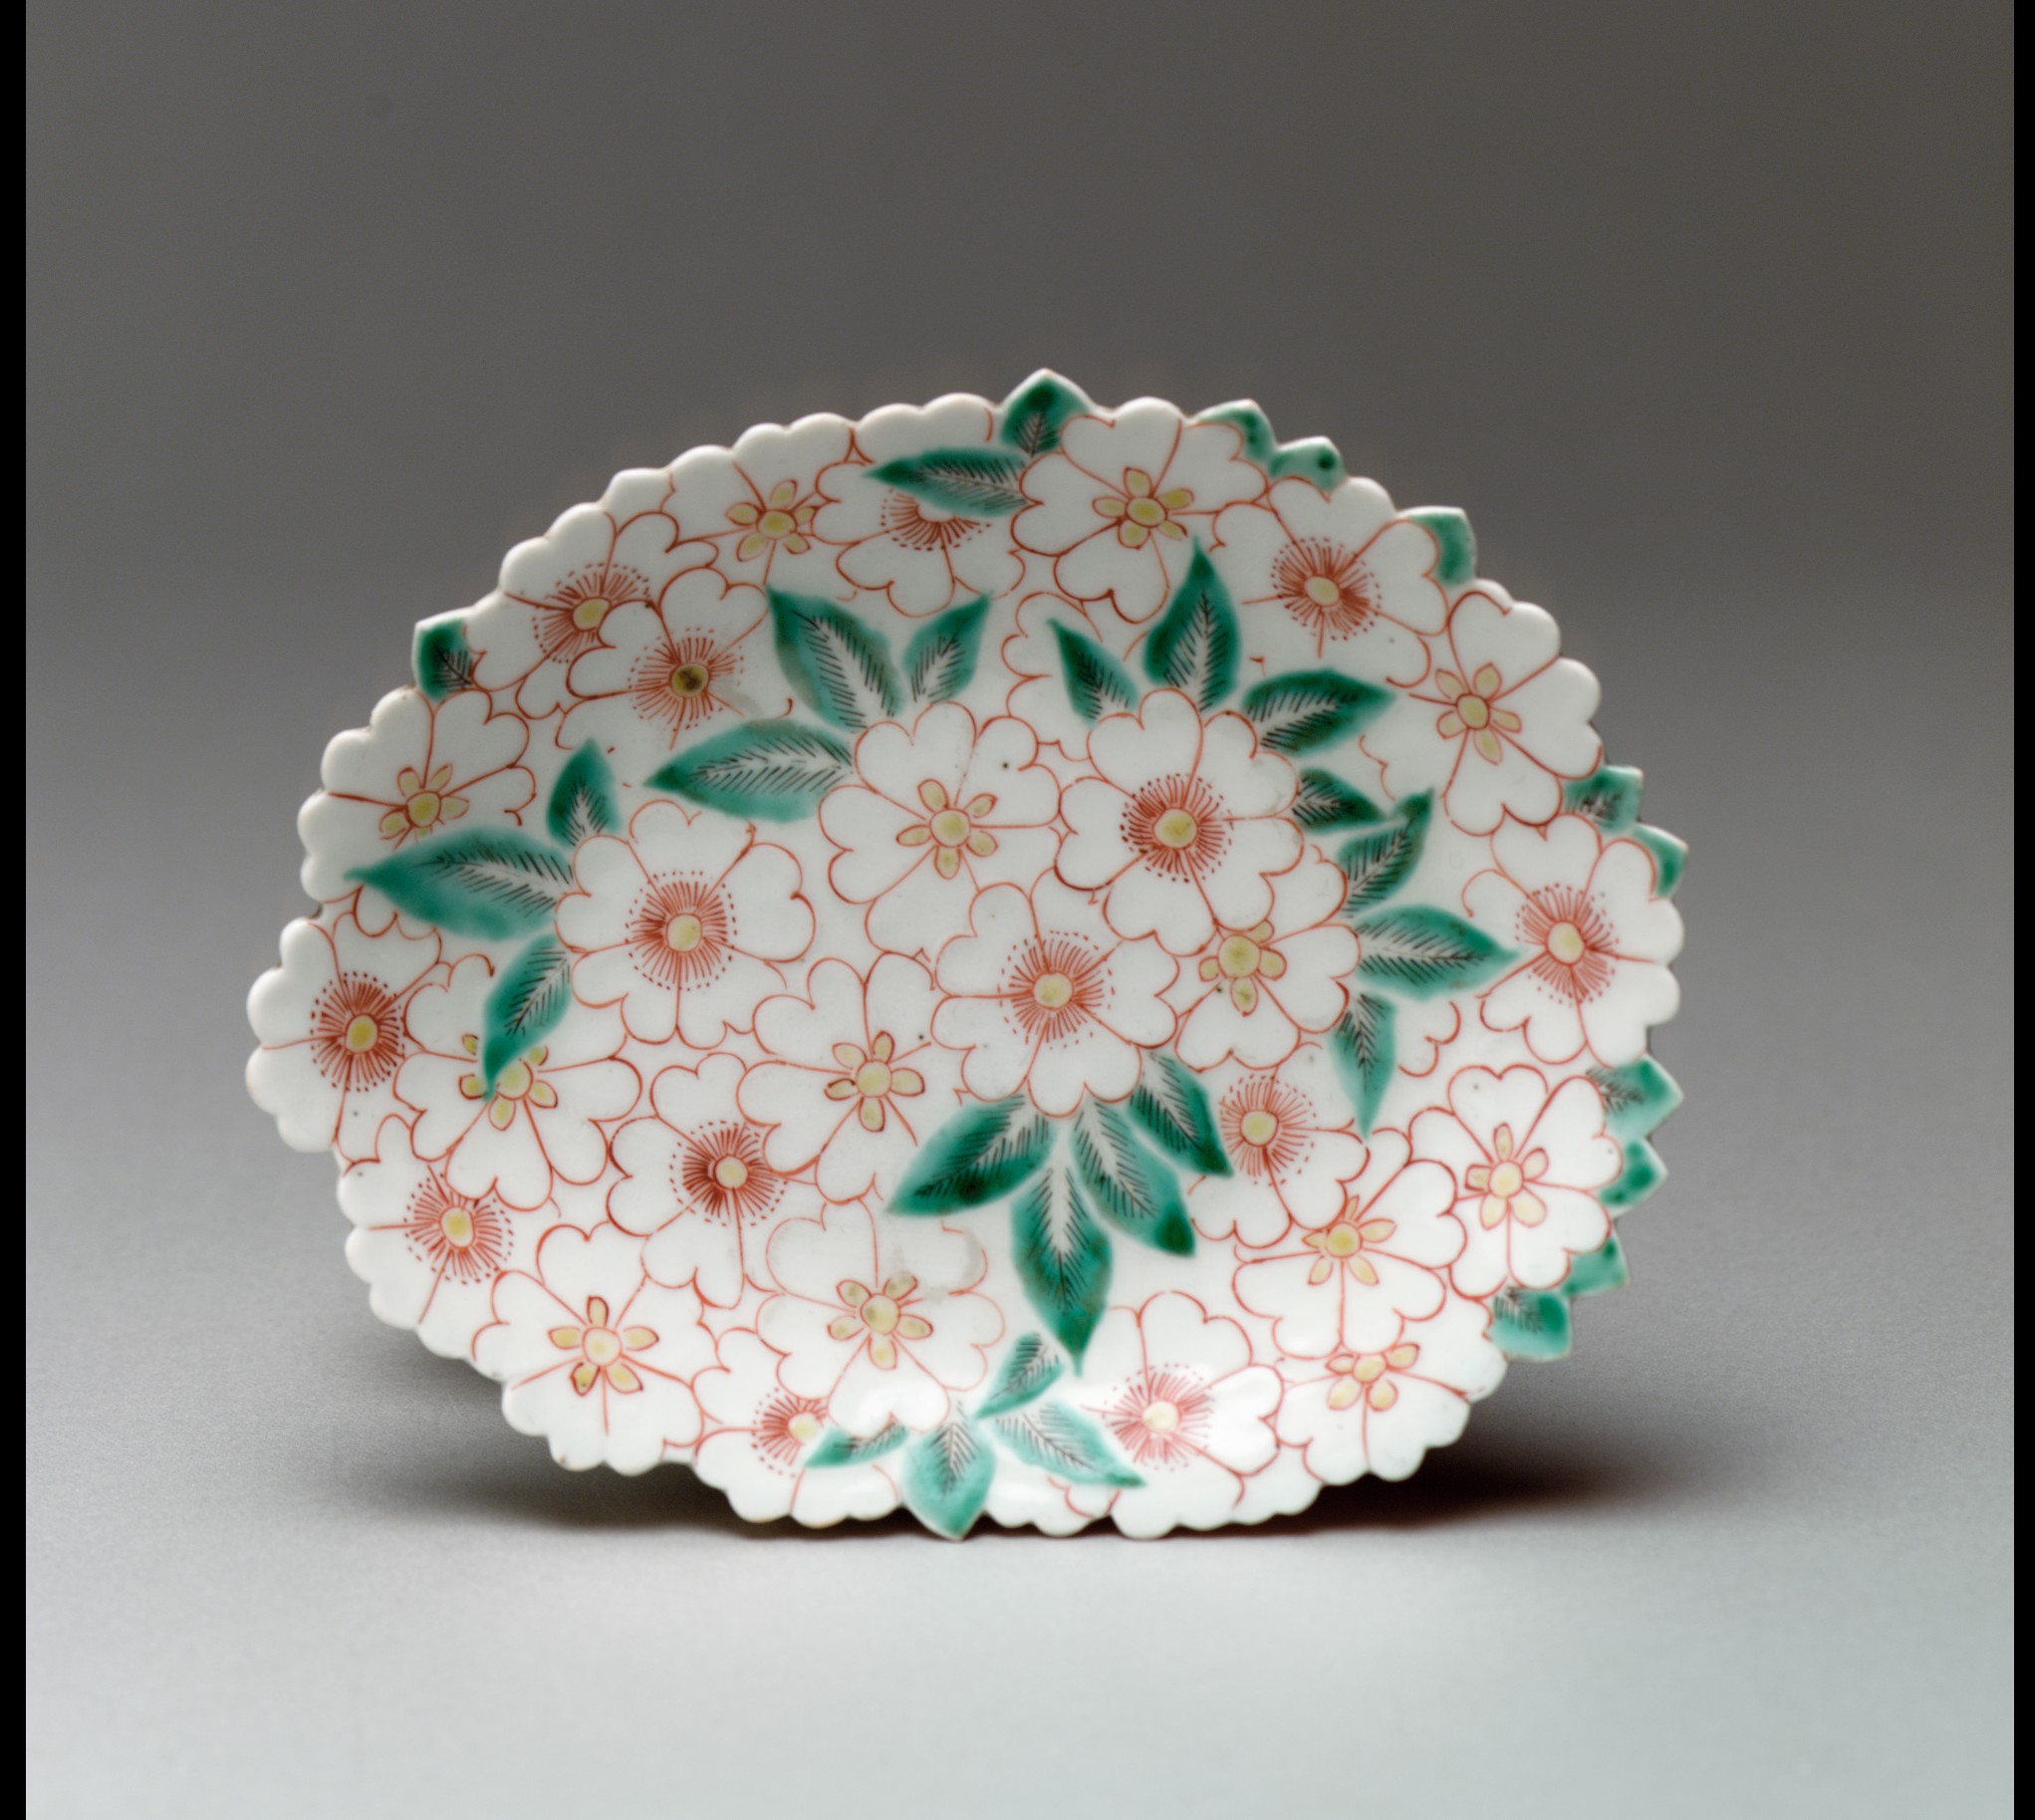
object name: dish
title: Dish with Cherry Blossoms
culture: japanese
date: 1634-1666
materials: enamel, porcelain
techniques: overglaze, polychrome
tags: flowers,leaves